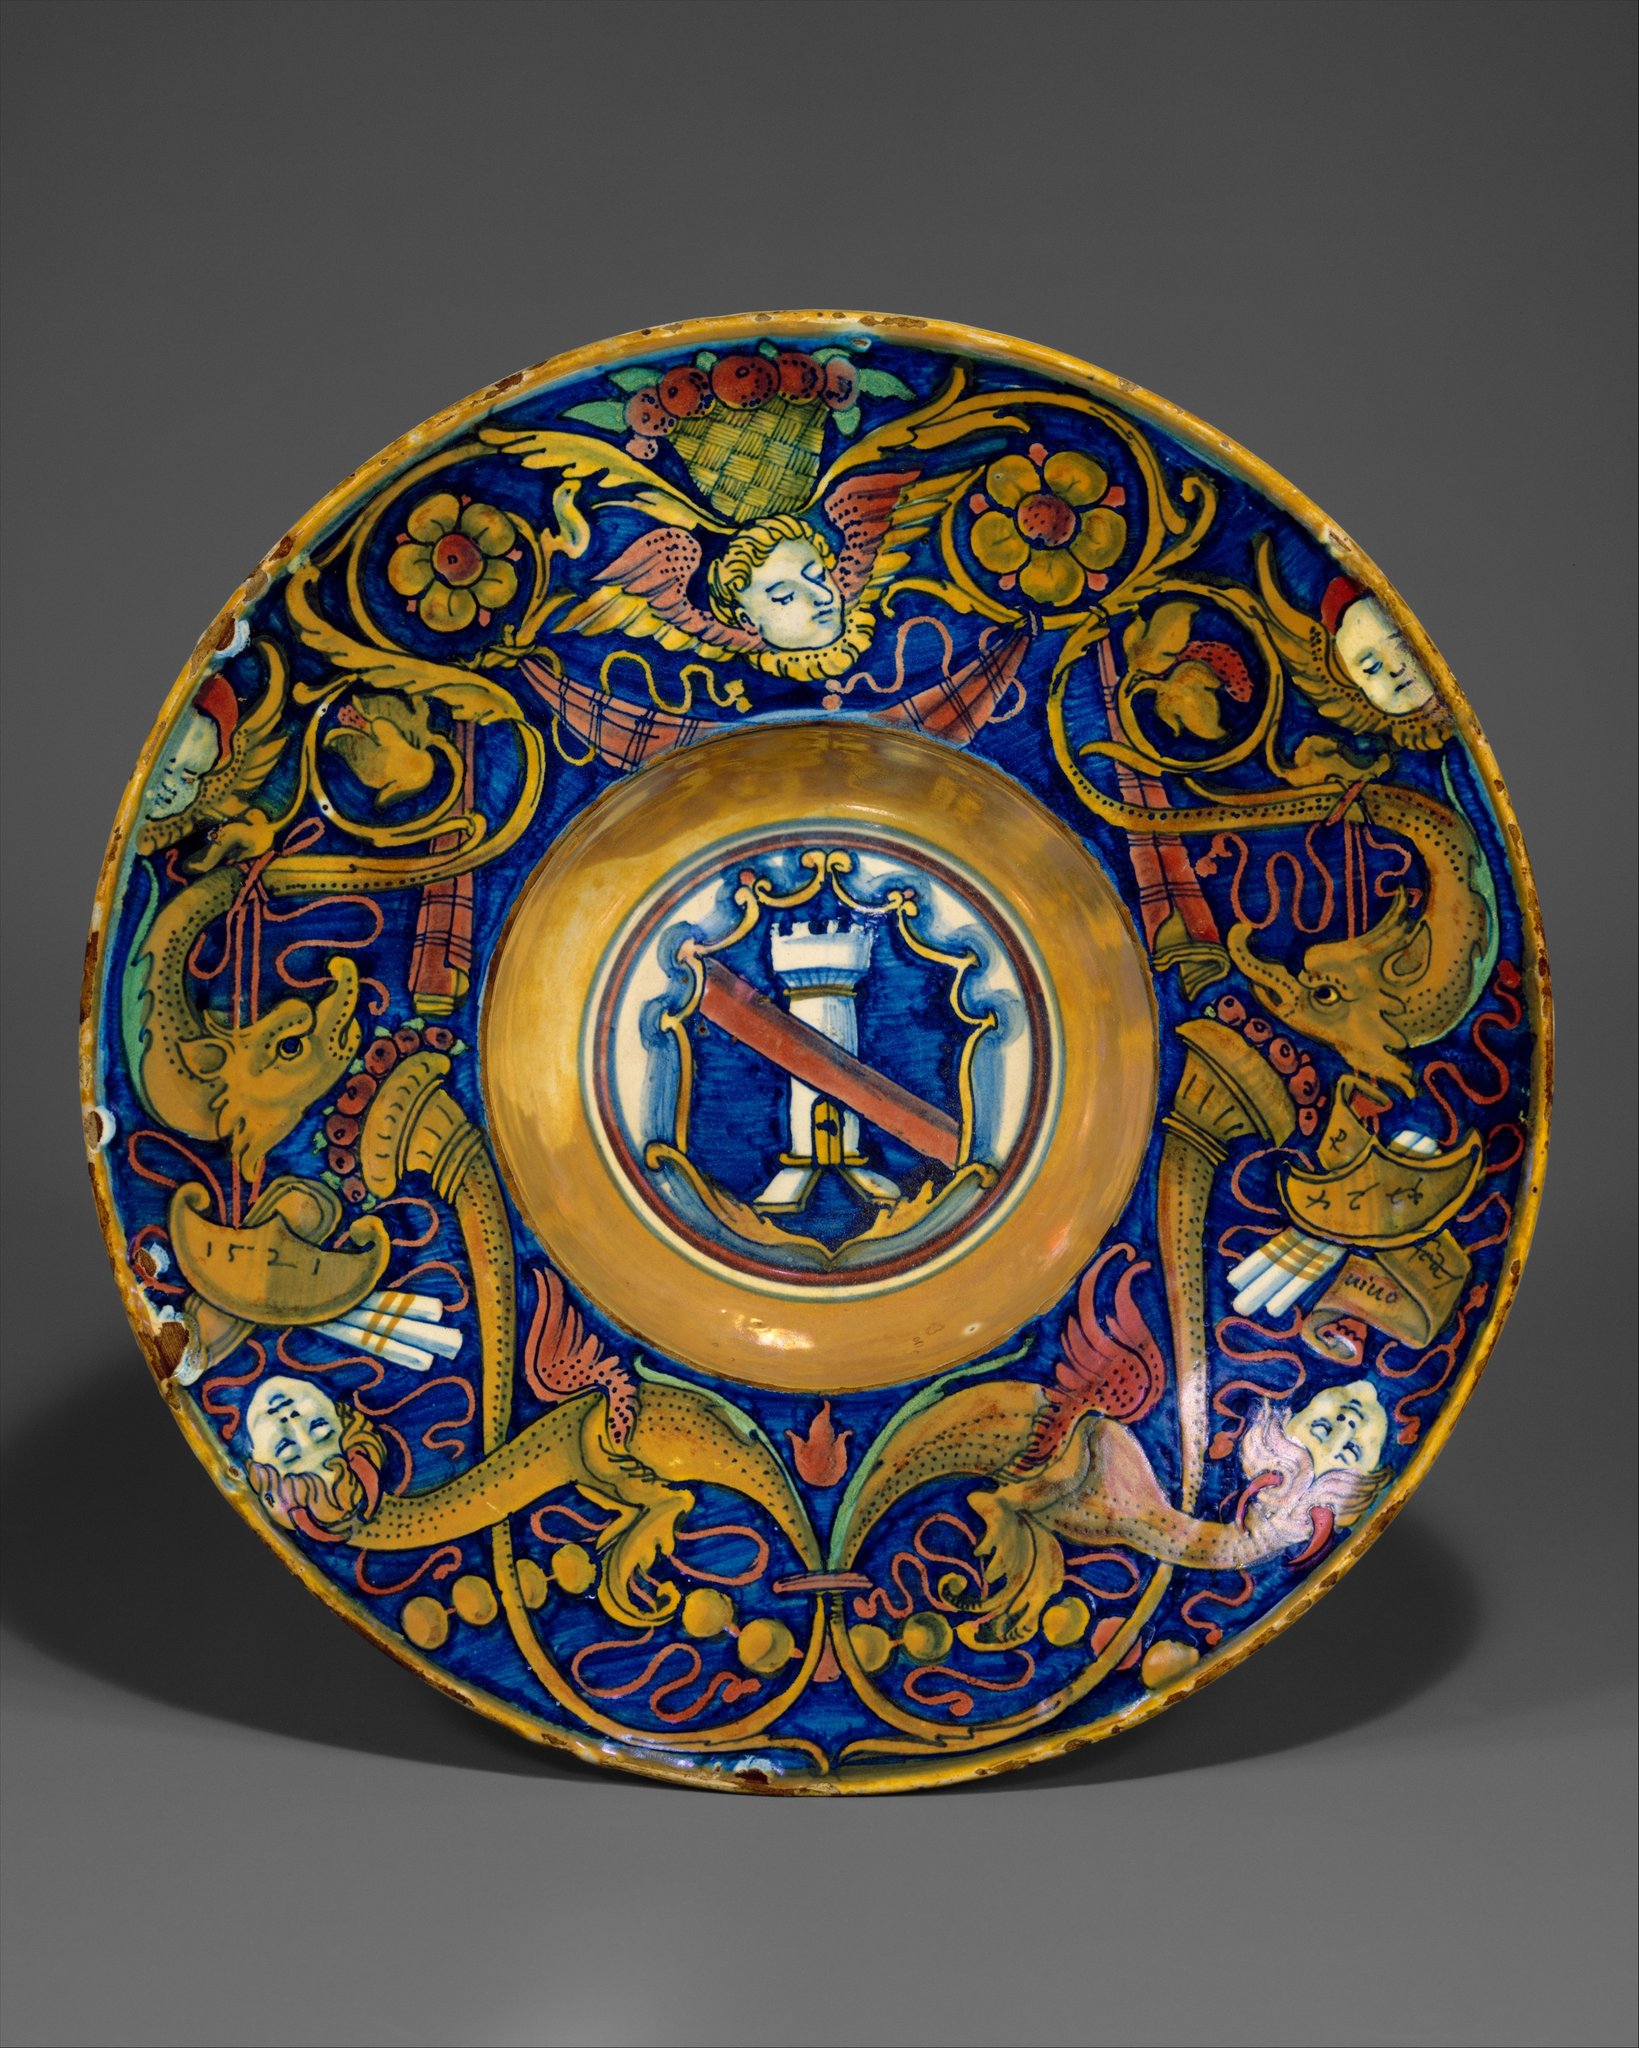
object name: dish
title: Dish (tondino)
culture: italian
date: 1521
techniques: maiolica, glazing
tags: coat of arms